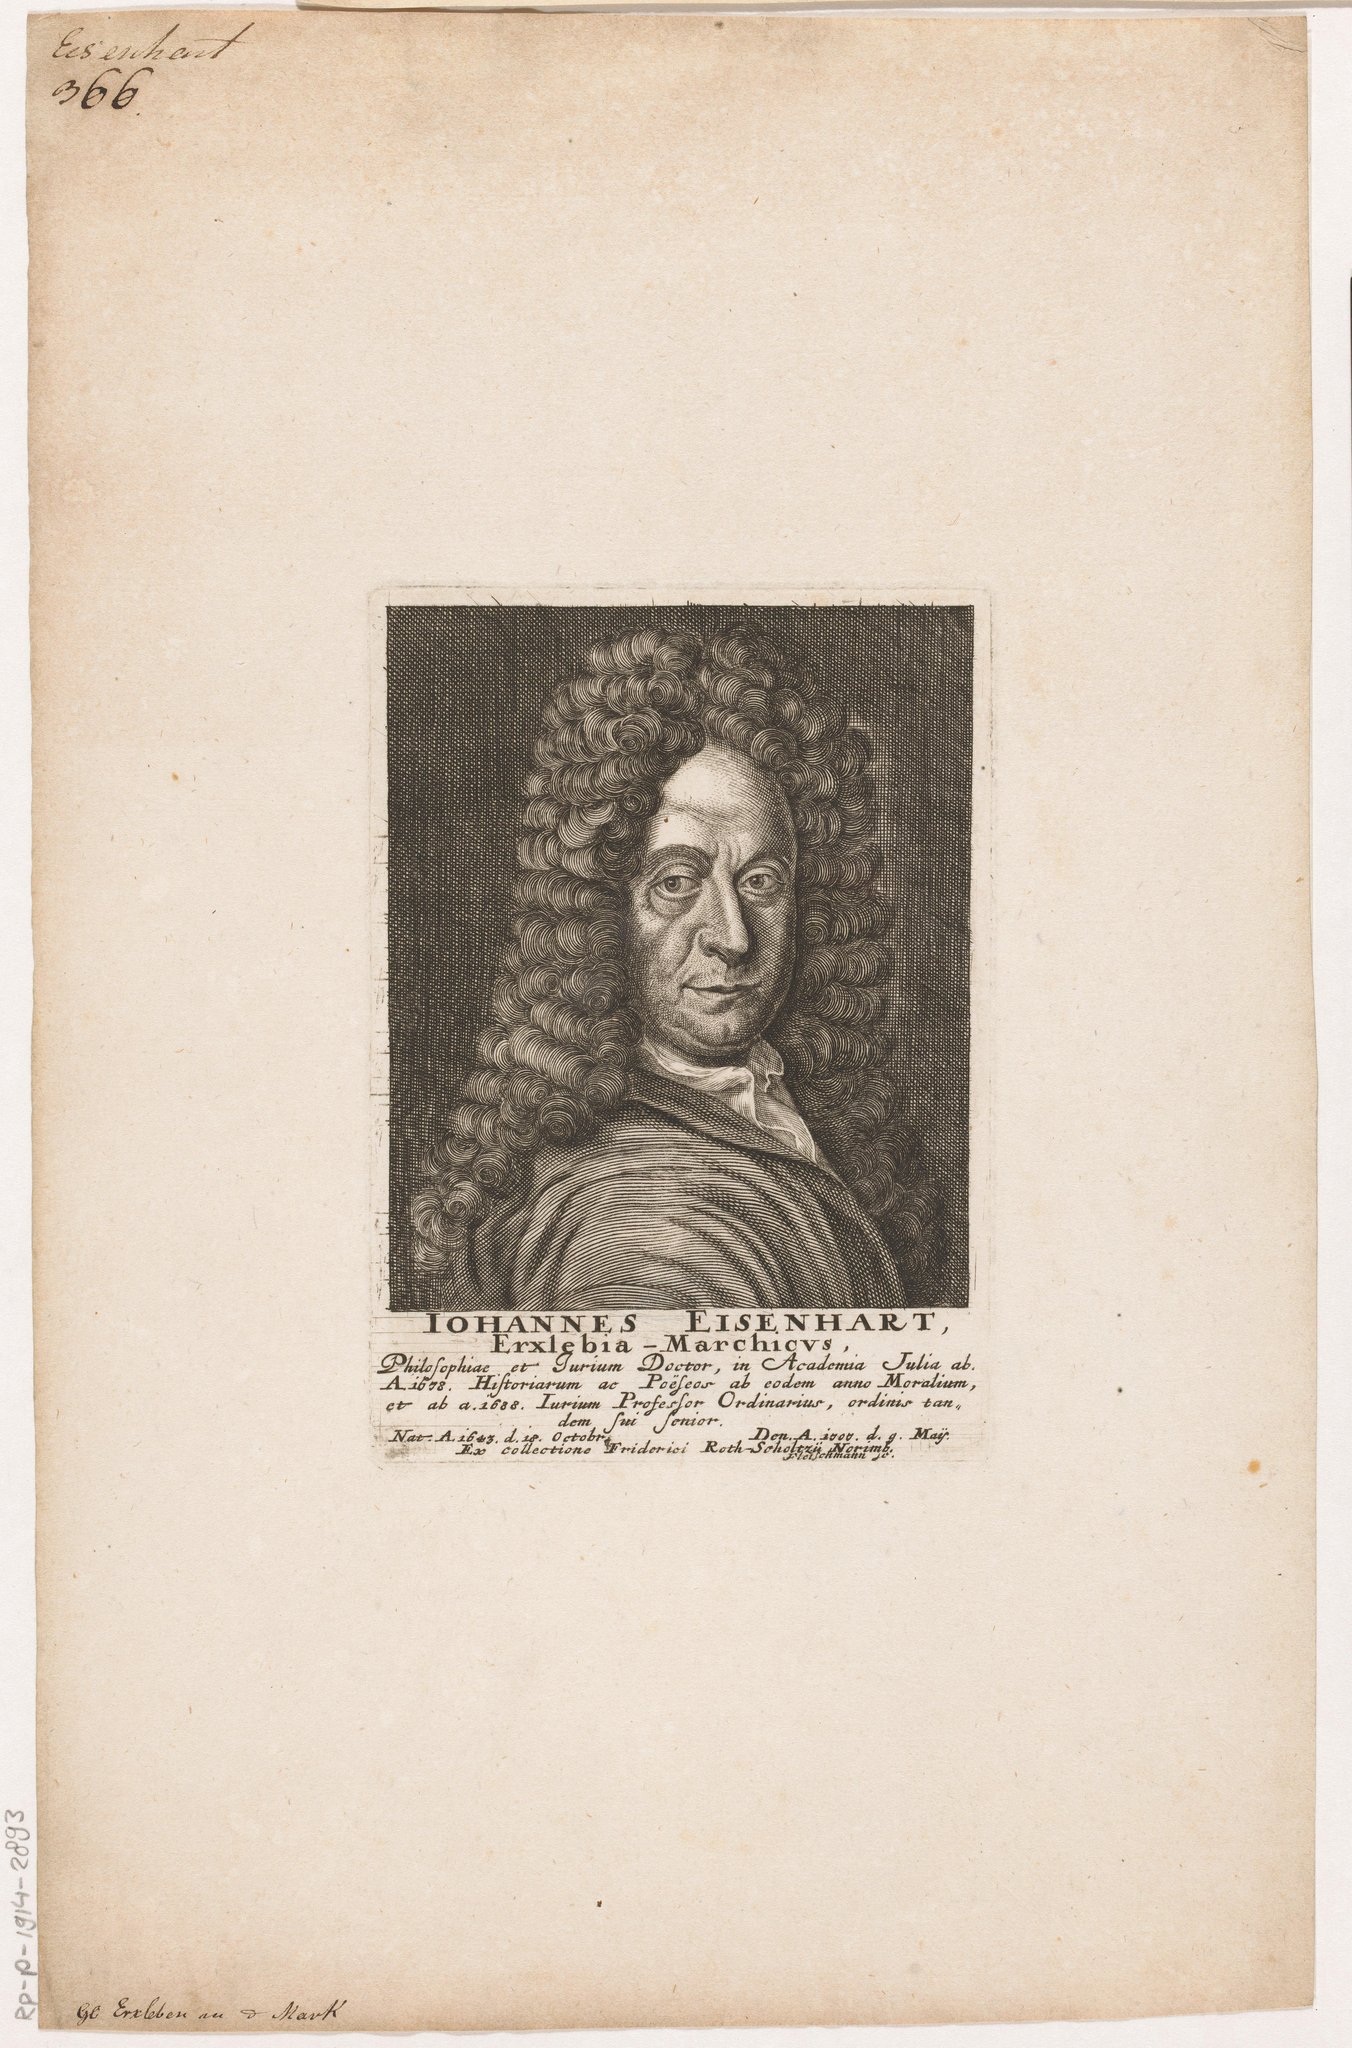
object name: print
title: Portret van Johannes Eisenhart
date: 1707-1732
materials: paper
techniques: engraving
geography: nuremberg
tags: historical persons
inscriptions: collector's mark: Lugt 2228